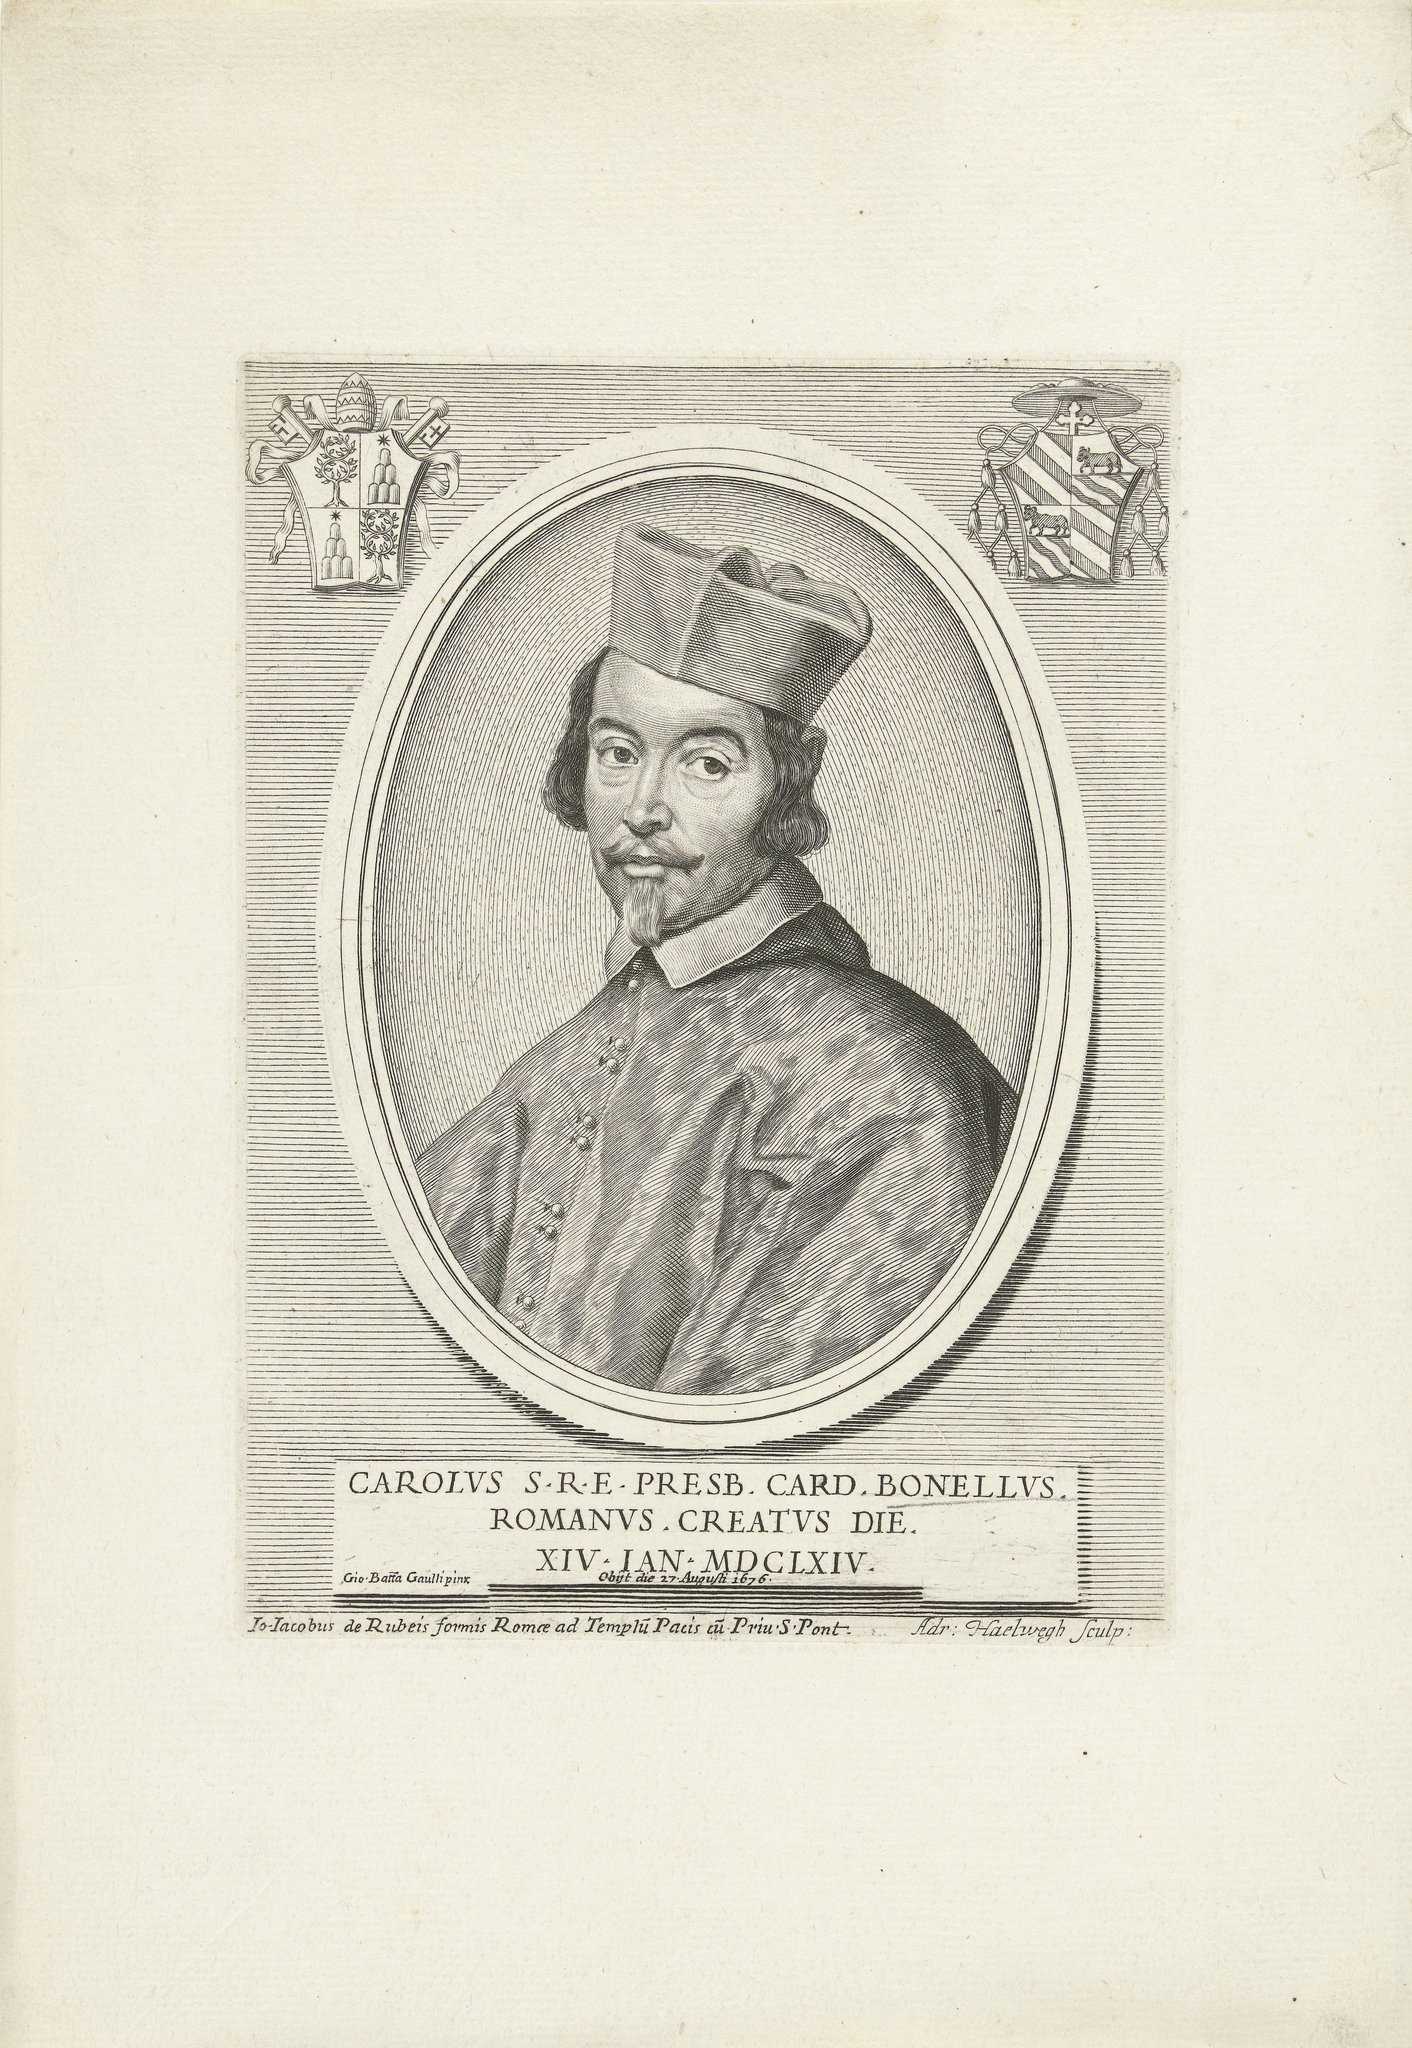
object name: print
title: Portret van kardinaal Carlo Bonnelli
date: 1676-1696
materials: paper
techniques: engraving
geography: rome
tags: insignia of the pope, e.g. tiara, insignia of cardinal, e.g. hat, mantle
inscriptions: collector's mark: Lugt 2228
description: Portret van kardinaal Carlo Bonnelli binnen een ovaal met daaronder een drieregelige tekst in Latijn en bovenaan het wapen van paus Alexander VII en een wapen met kruis, een hoed en zes kwasten.